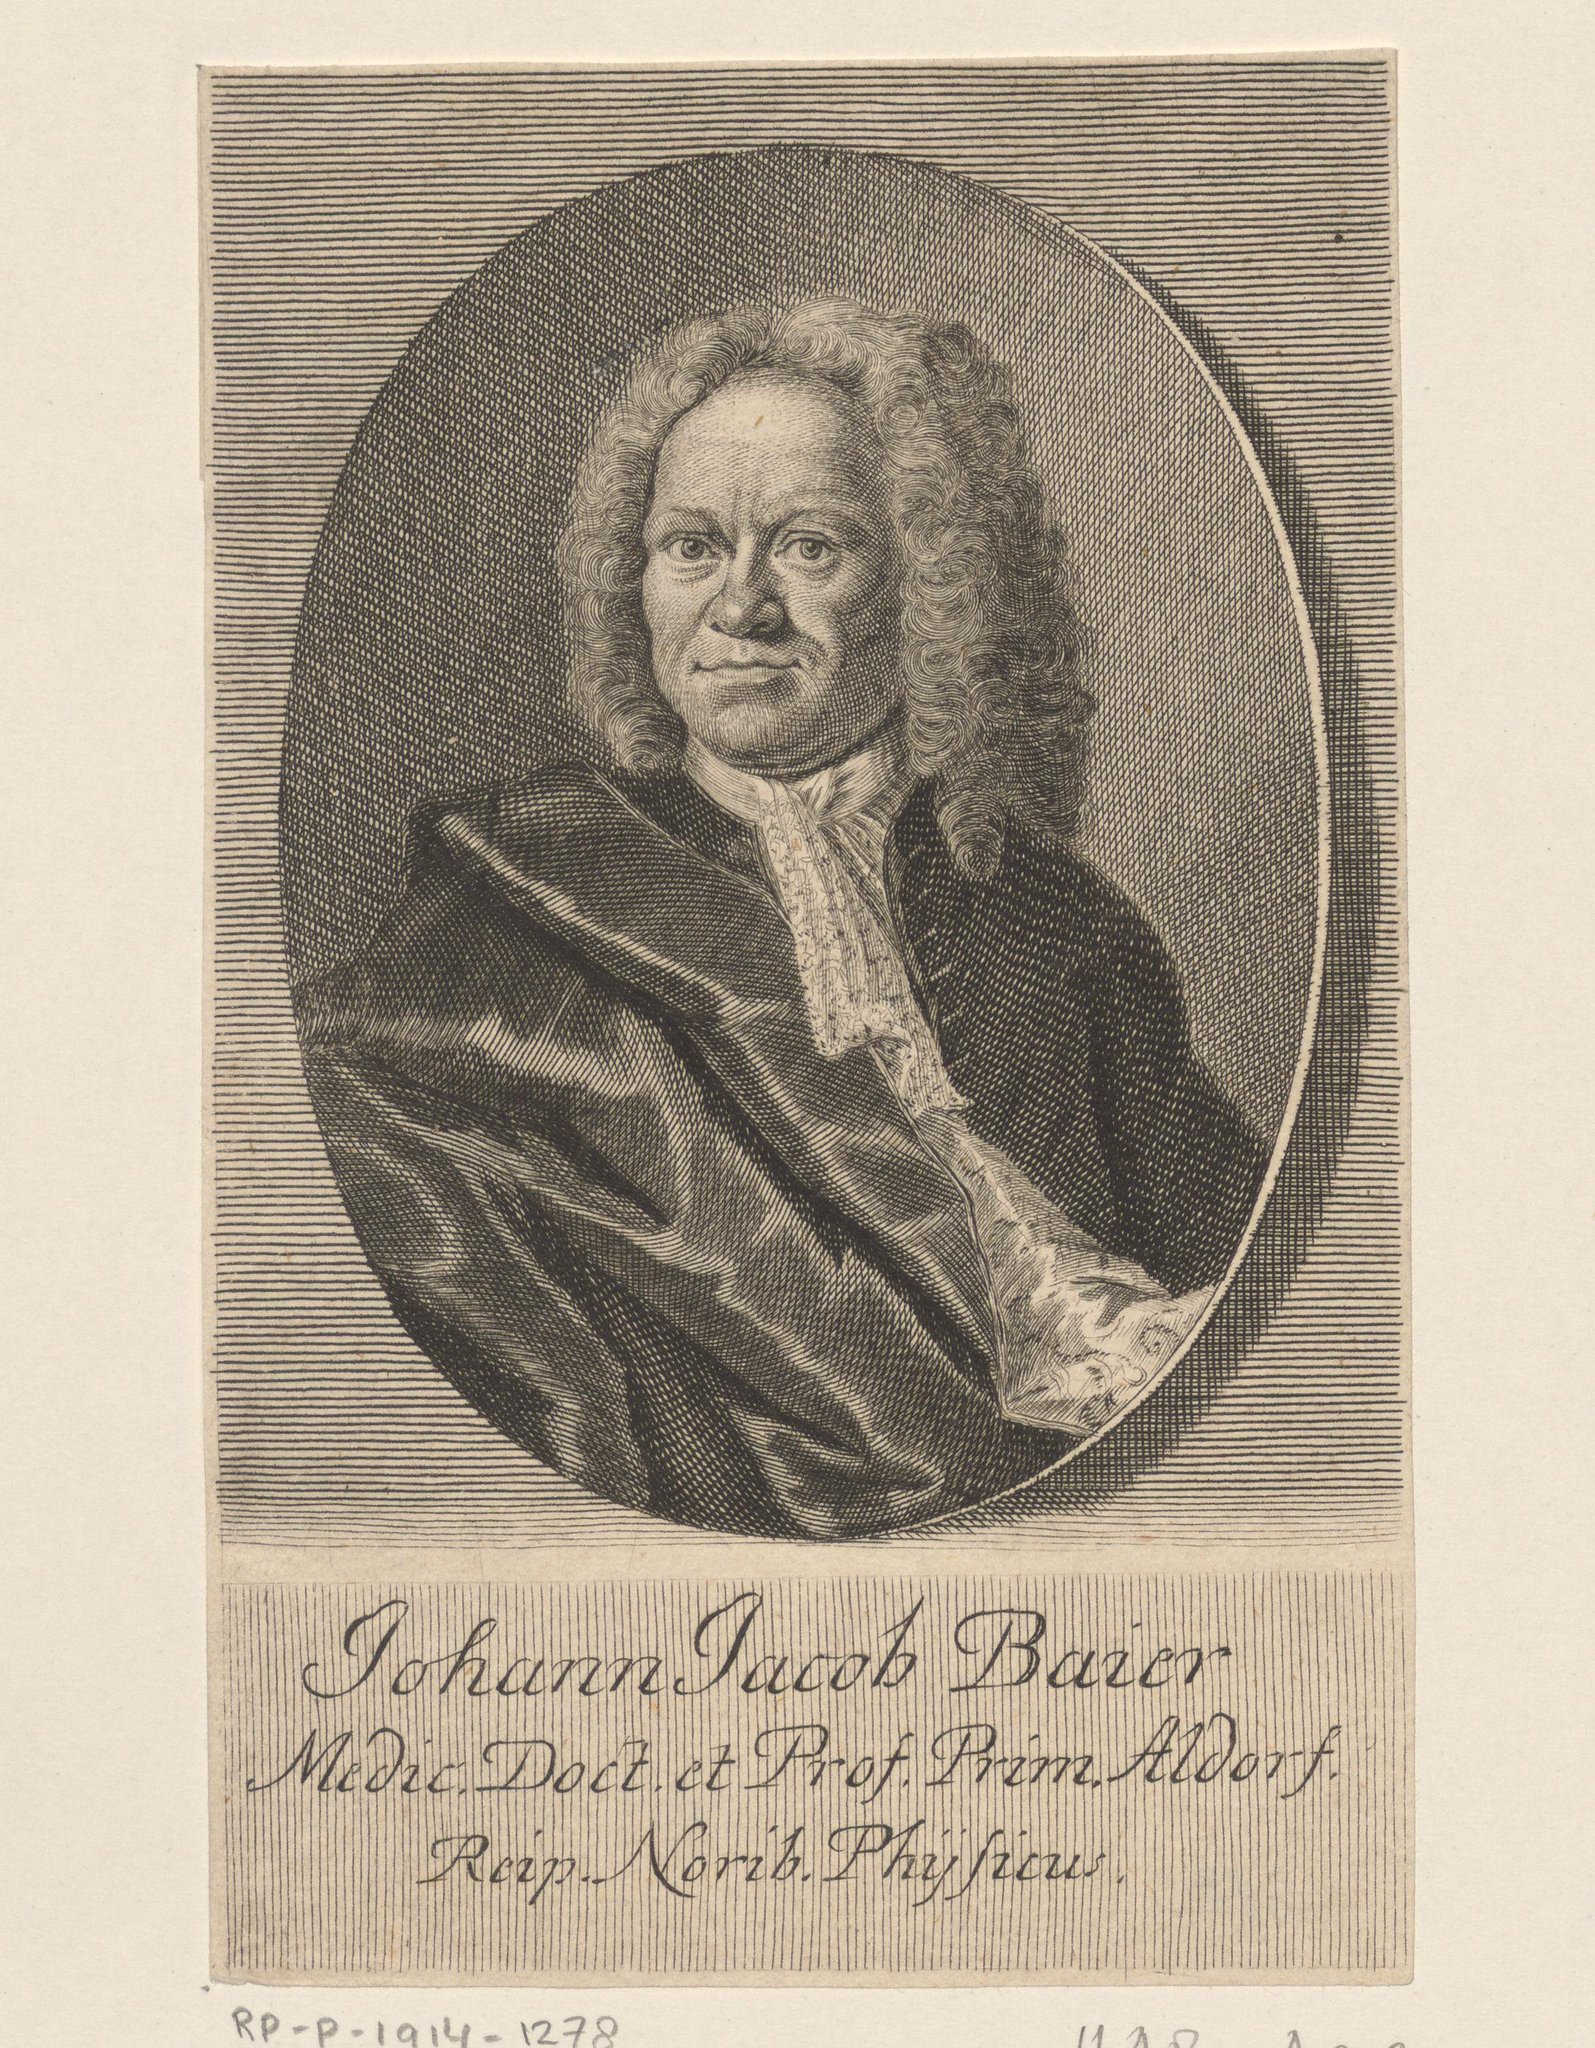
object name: print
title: Portret van Johann Jacob Baier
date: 1727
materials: paper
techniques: engraving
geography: leipzig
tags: johann jacob baier (i), historical persons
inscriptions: collector's mark: Lugt 2228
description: Prent uit: Deutsche Acta Eruditorum. Leipzig: Johann Gottlieb Gleditsch, 1727, dl. 123.